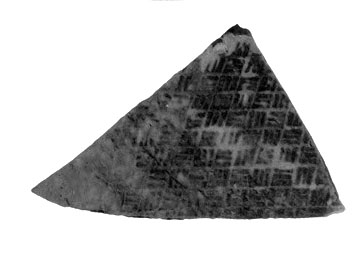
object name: fragment of a jar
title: Fragment of a Jar (Study Collection)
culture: chinese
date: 1046-256 BCE